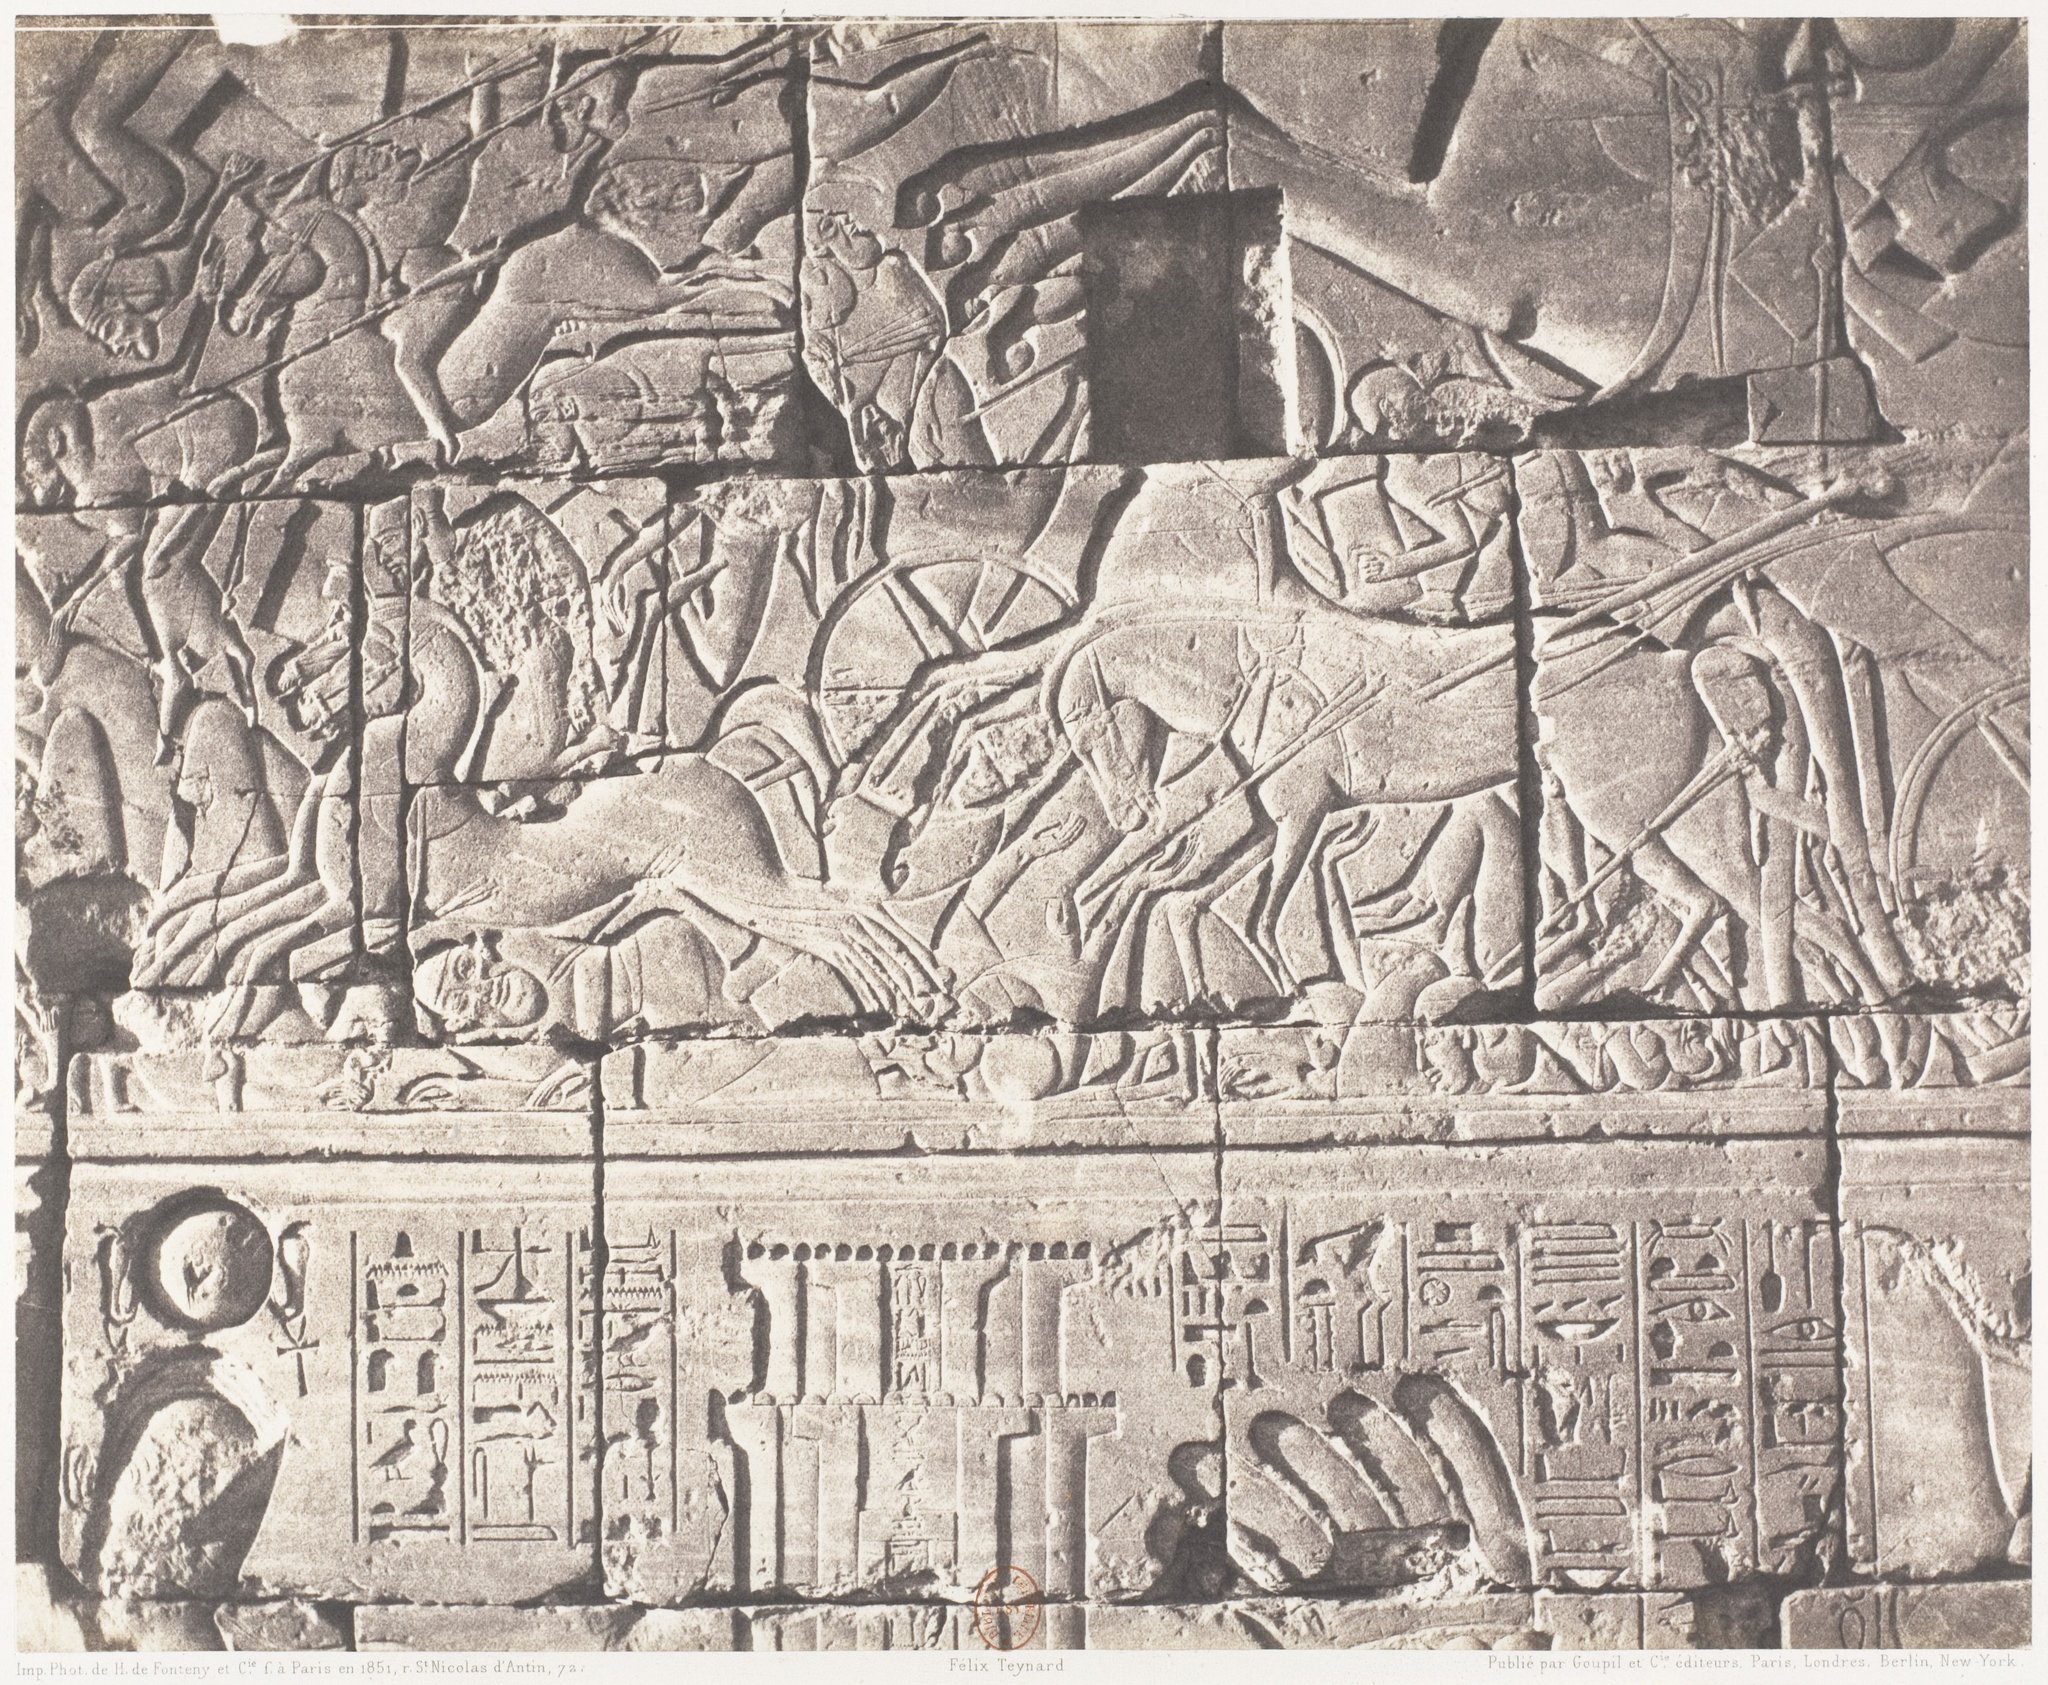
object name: photograph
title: Karnak (Thèbes), Enciente du Palais - Détails de Sculptures au Point O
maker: félix teynard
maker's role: artist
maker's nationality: french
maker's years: 1817-1892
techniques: paper negative, salted paper print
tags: sculpture,horses